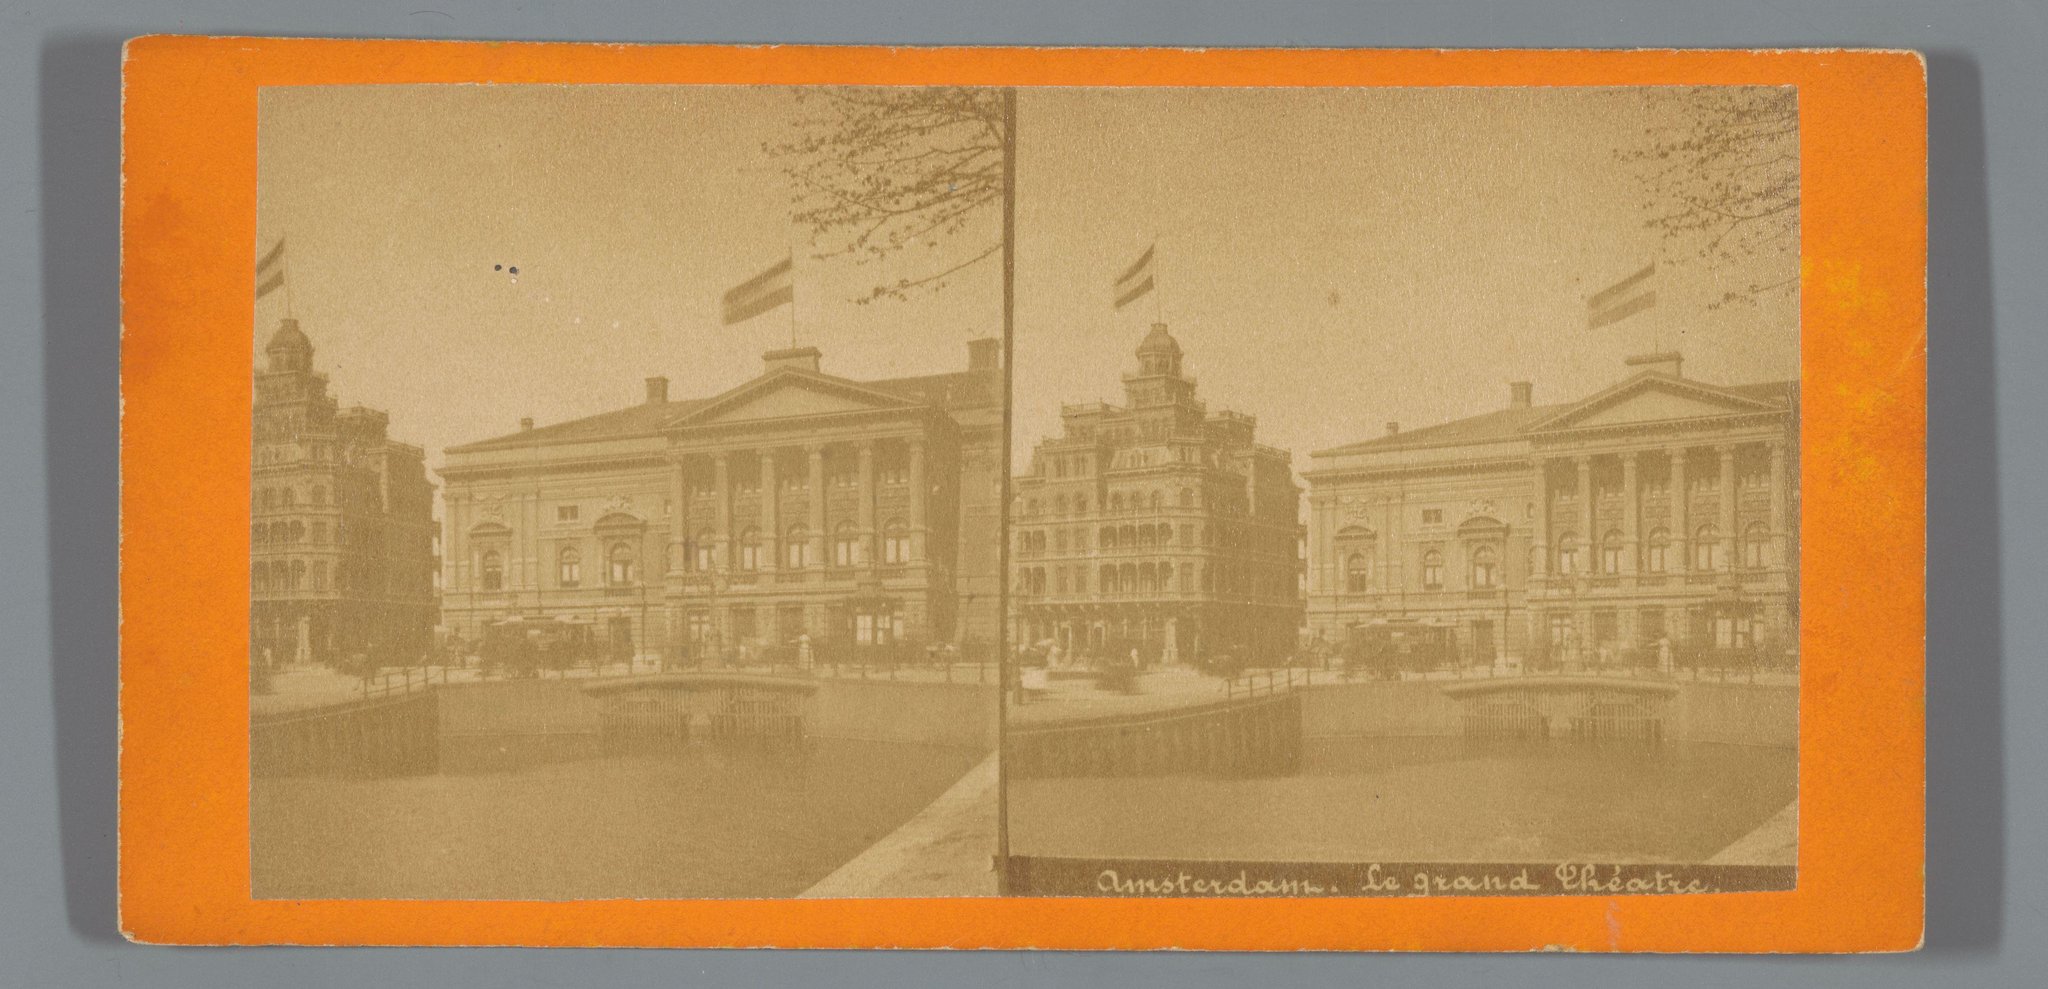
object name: stereograph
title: Stadsschouwburg en het American Hotel aan het Leidseplein, gezien vanaf de Lijnbaansgracht, Amsterdam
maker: Anonymous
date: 1882-1888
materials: cardboard, paper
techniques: albumen print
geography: amsterdam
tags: theatre (building), canals, waters (in city)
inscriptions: initials: ‘IB [?]’